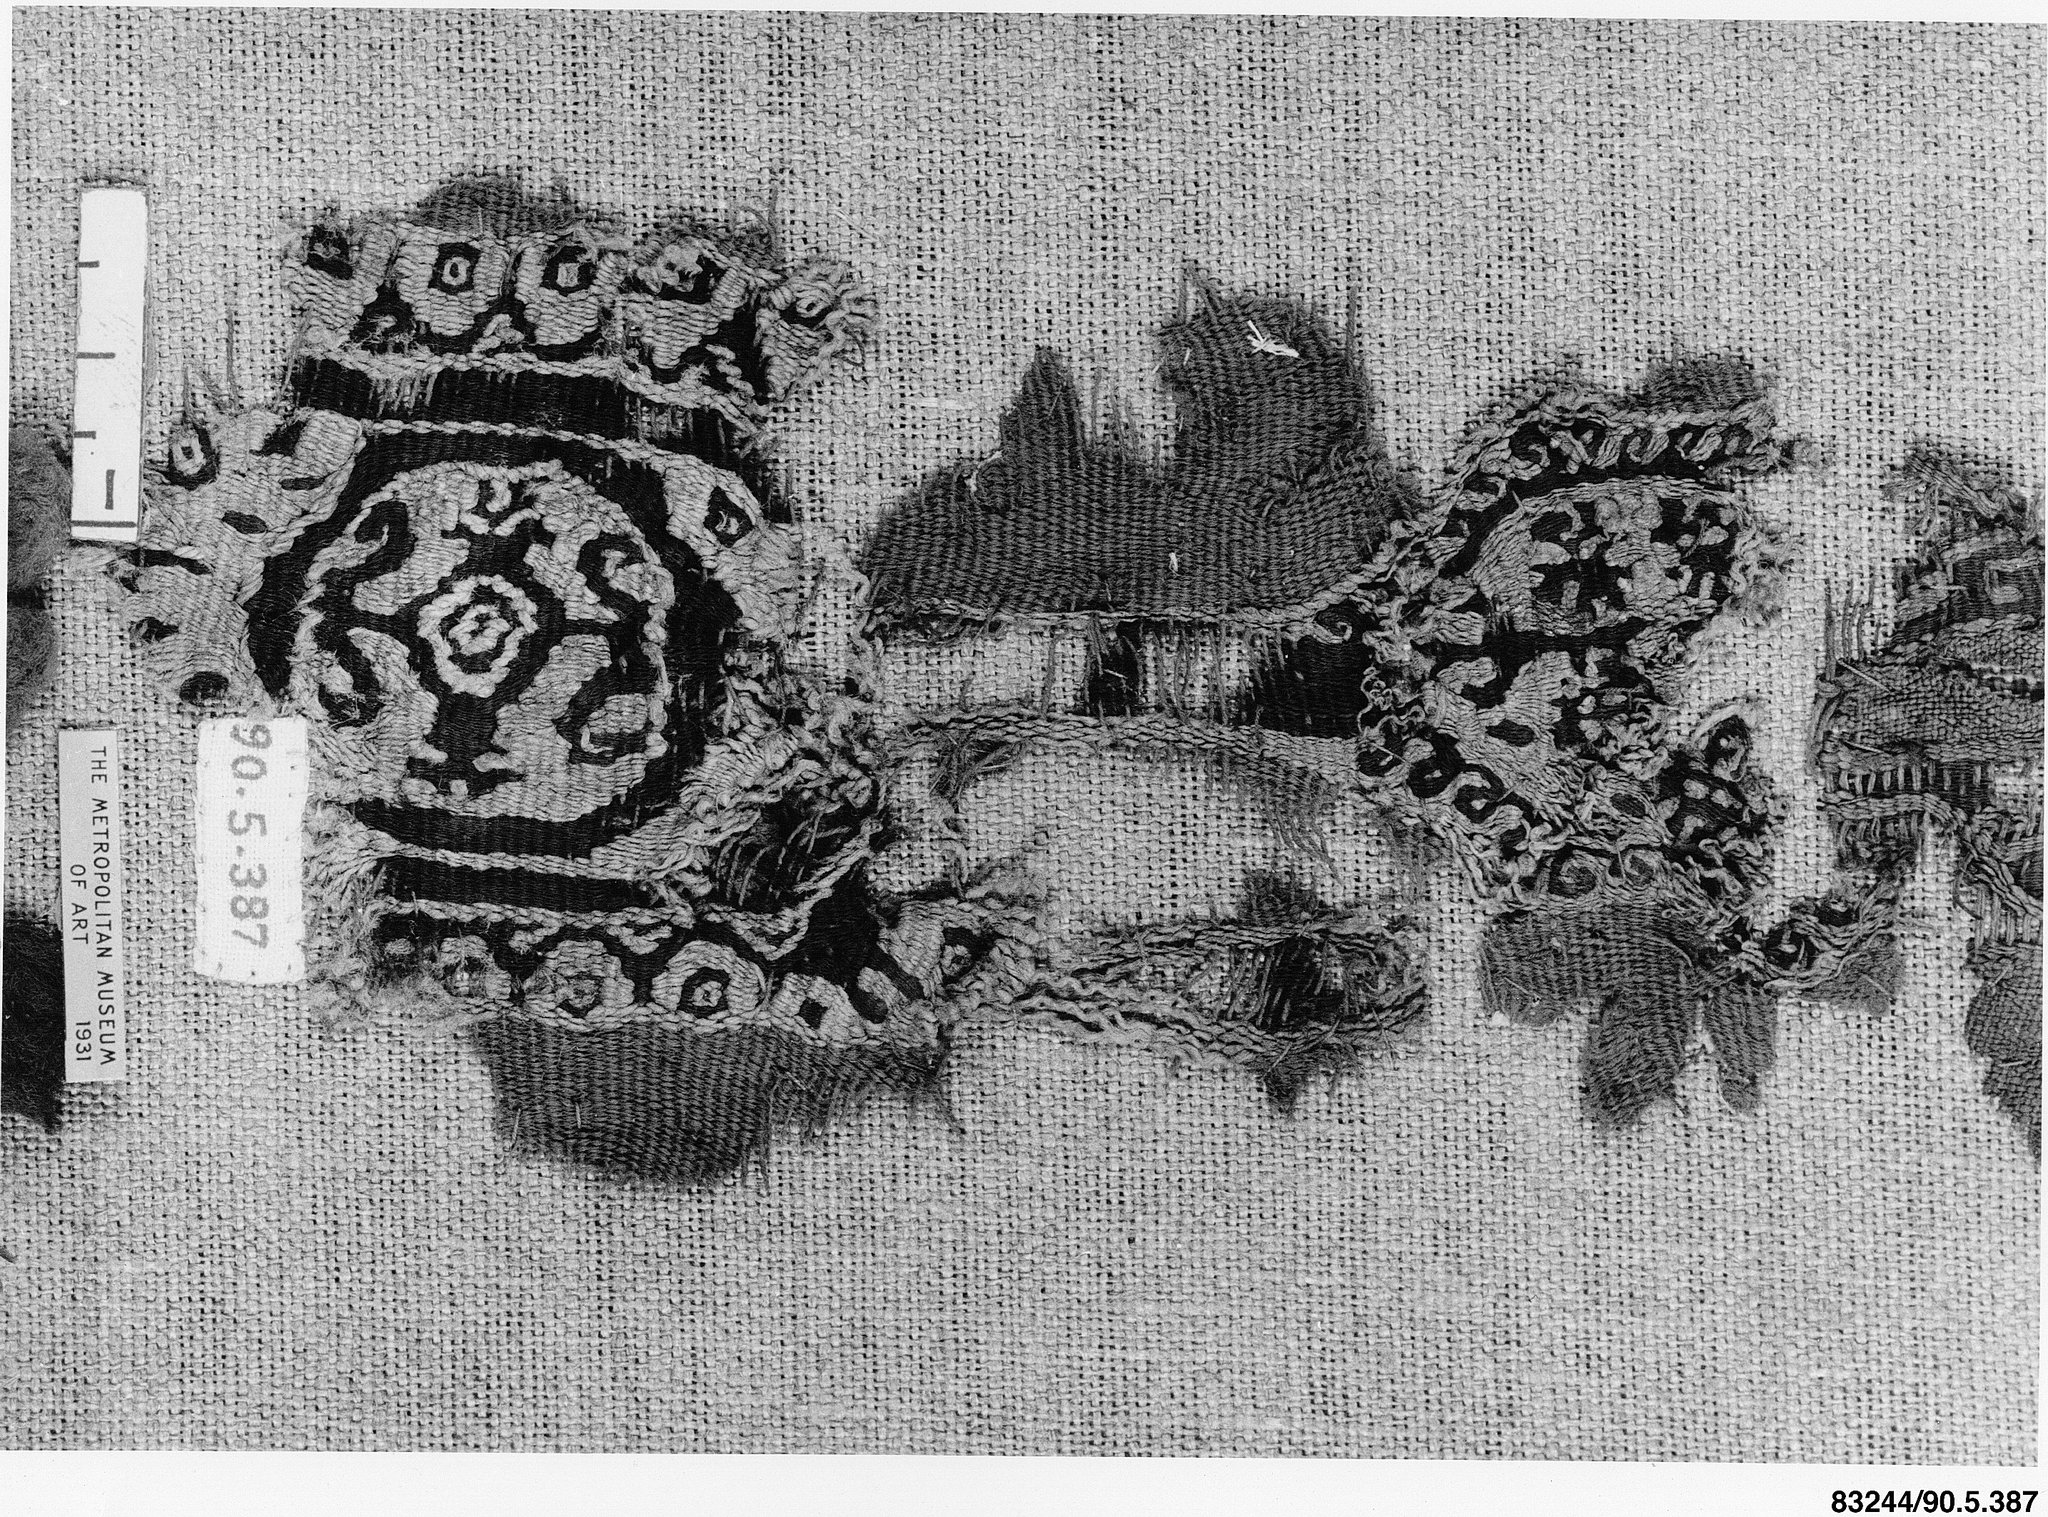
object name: textile fragment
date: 301-500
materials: linen, wool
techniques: weave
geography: egypt